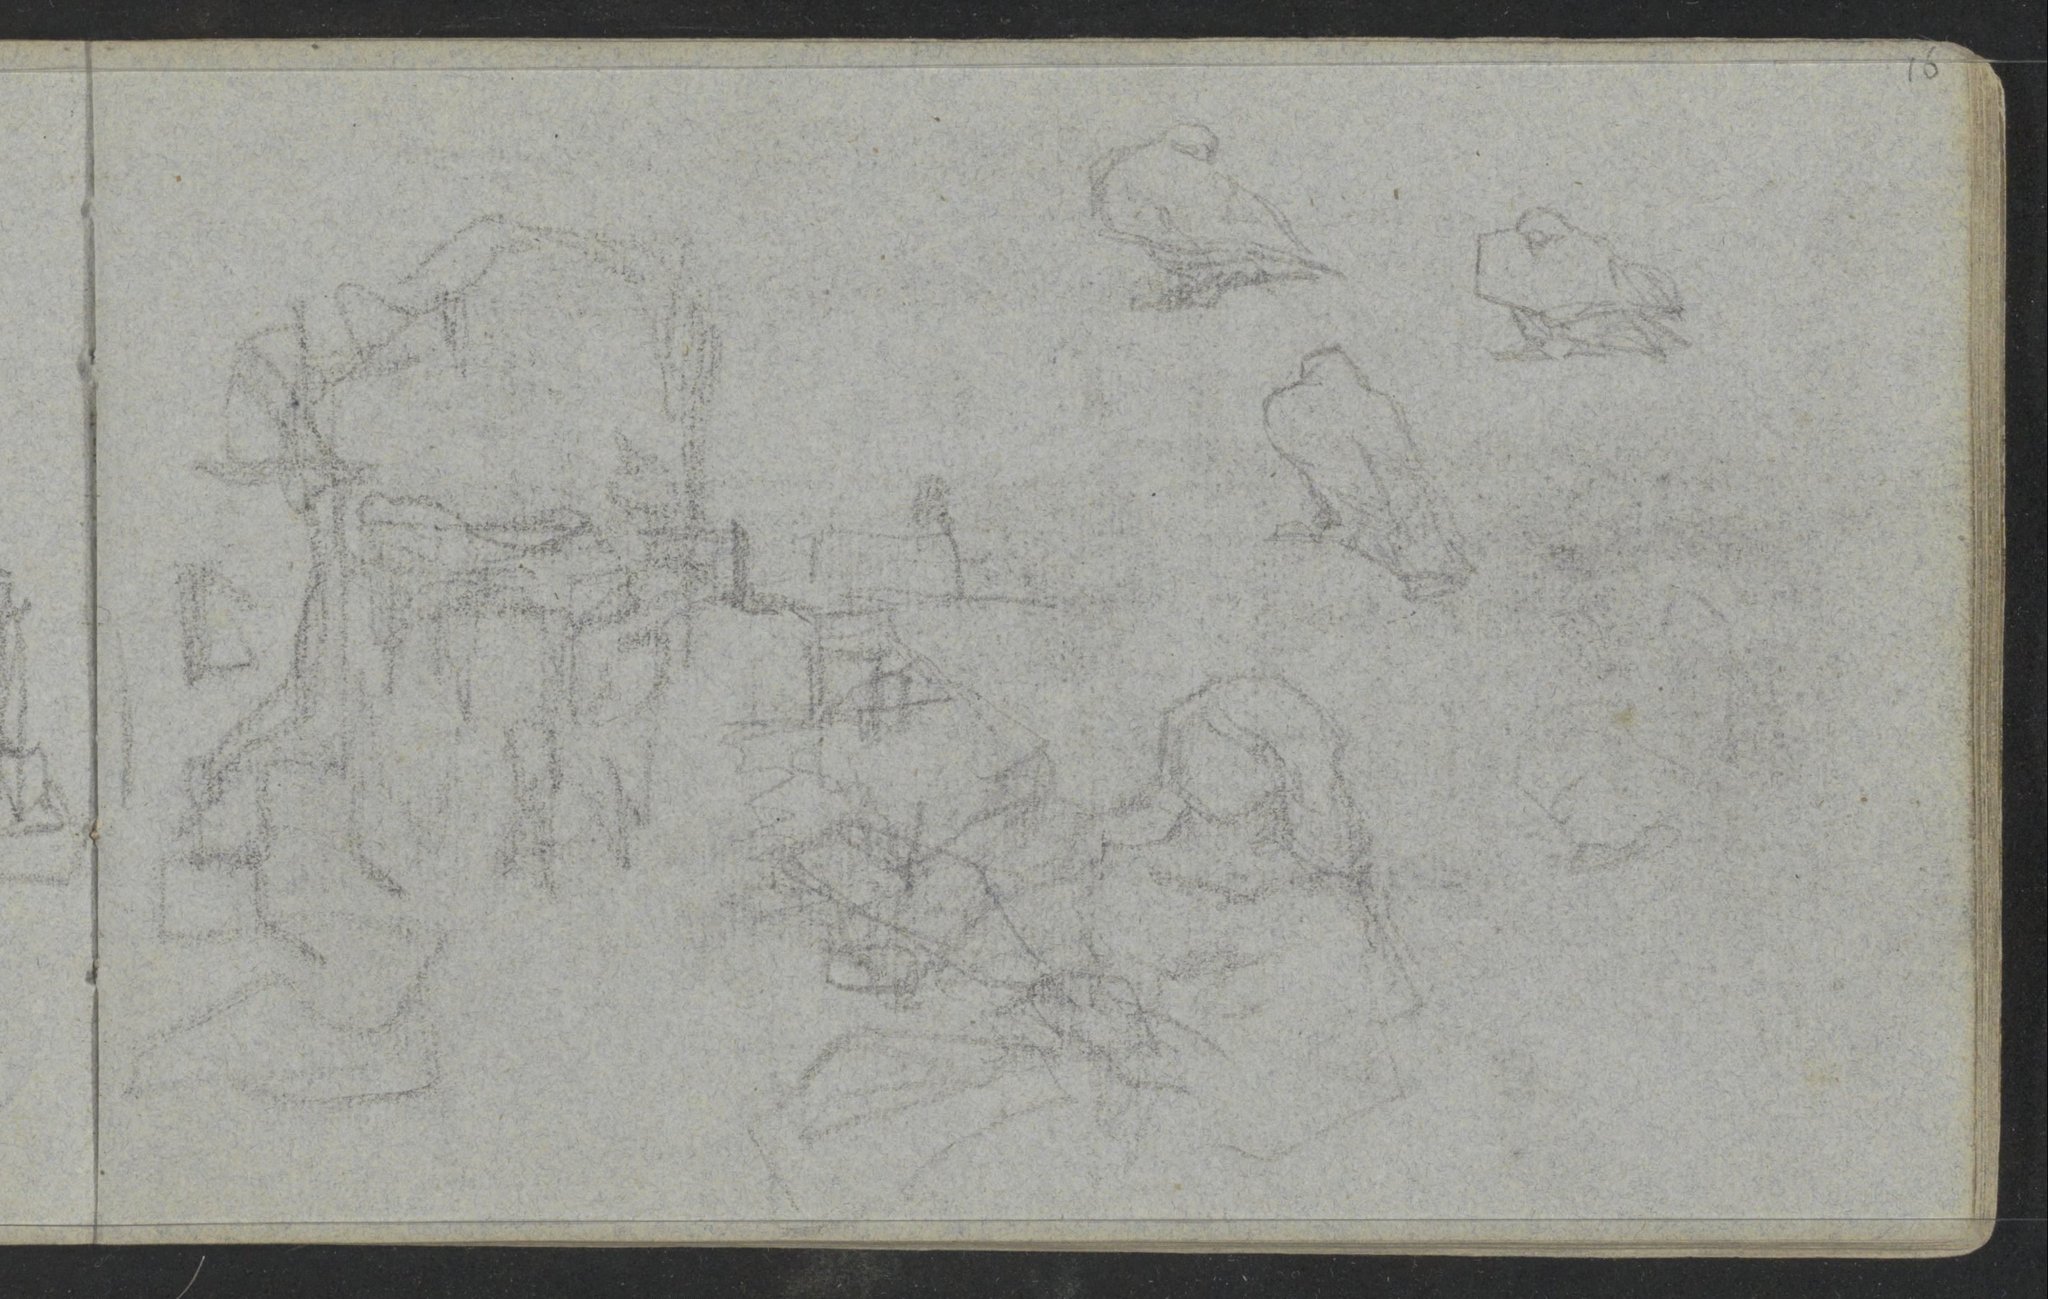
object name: sketchbook leaf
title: Studieblad, onder andere met vogels en een meisje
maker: matthijs maris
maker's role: draughtsman, painter, print maker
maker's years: 1839-1917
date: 1849-1917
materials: paper, pencil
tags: birds, girl (child between toddler and youth)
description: Blad 16 recto uit een schetsboek met 35 bladen.